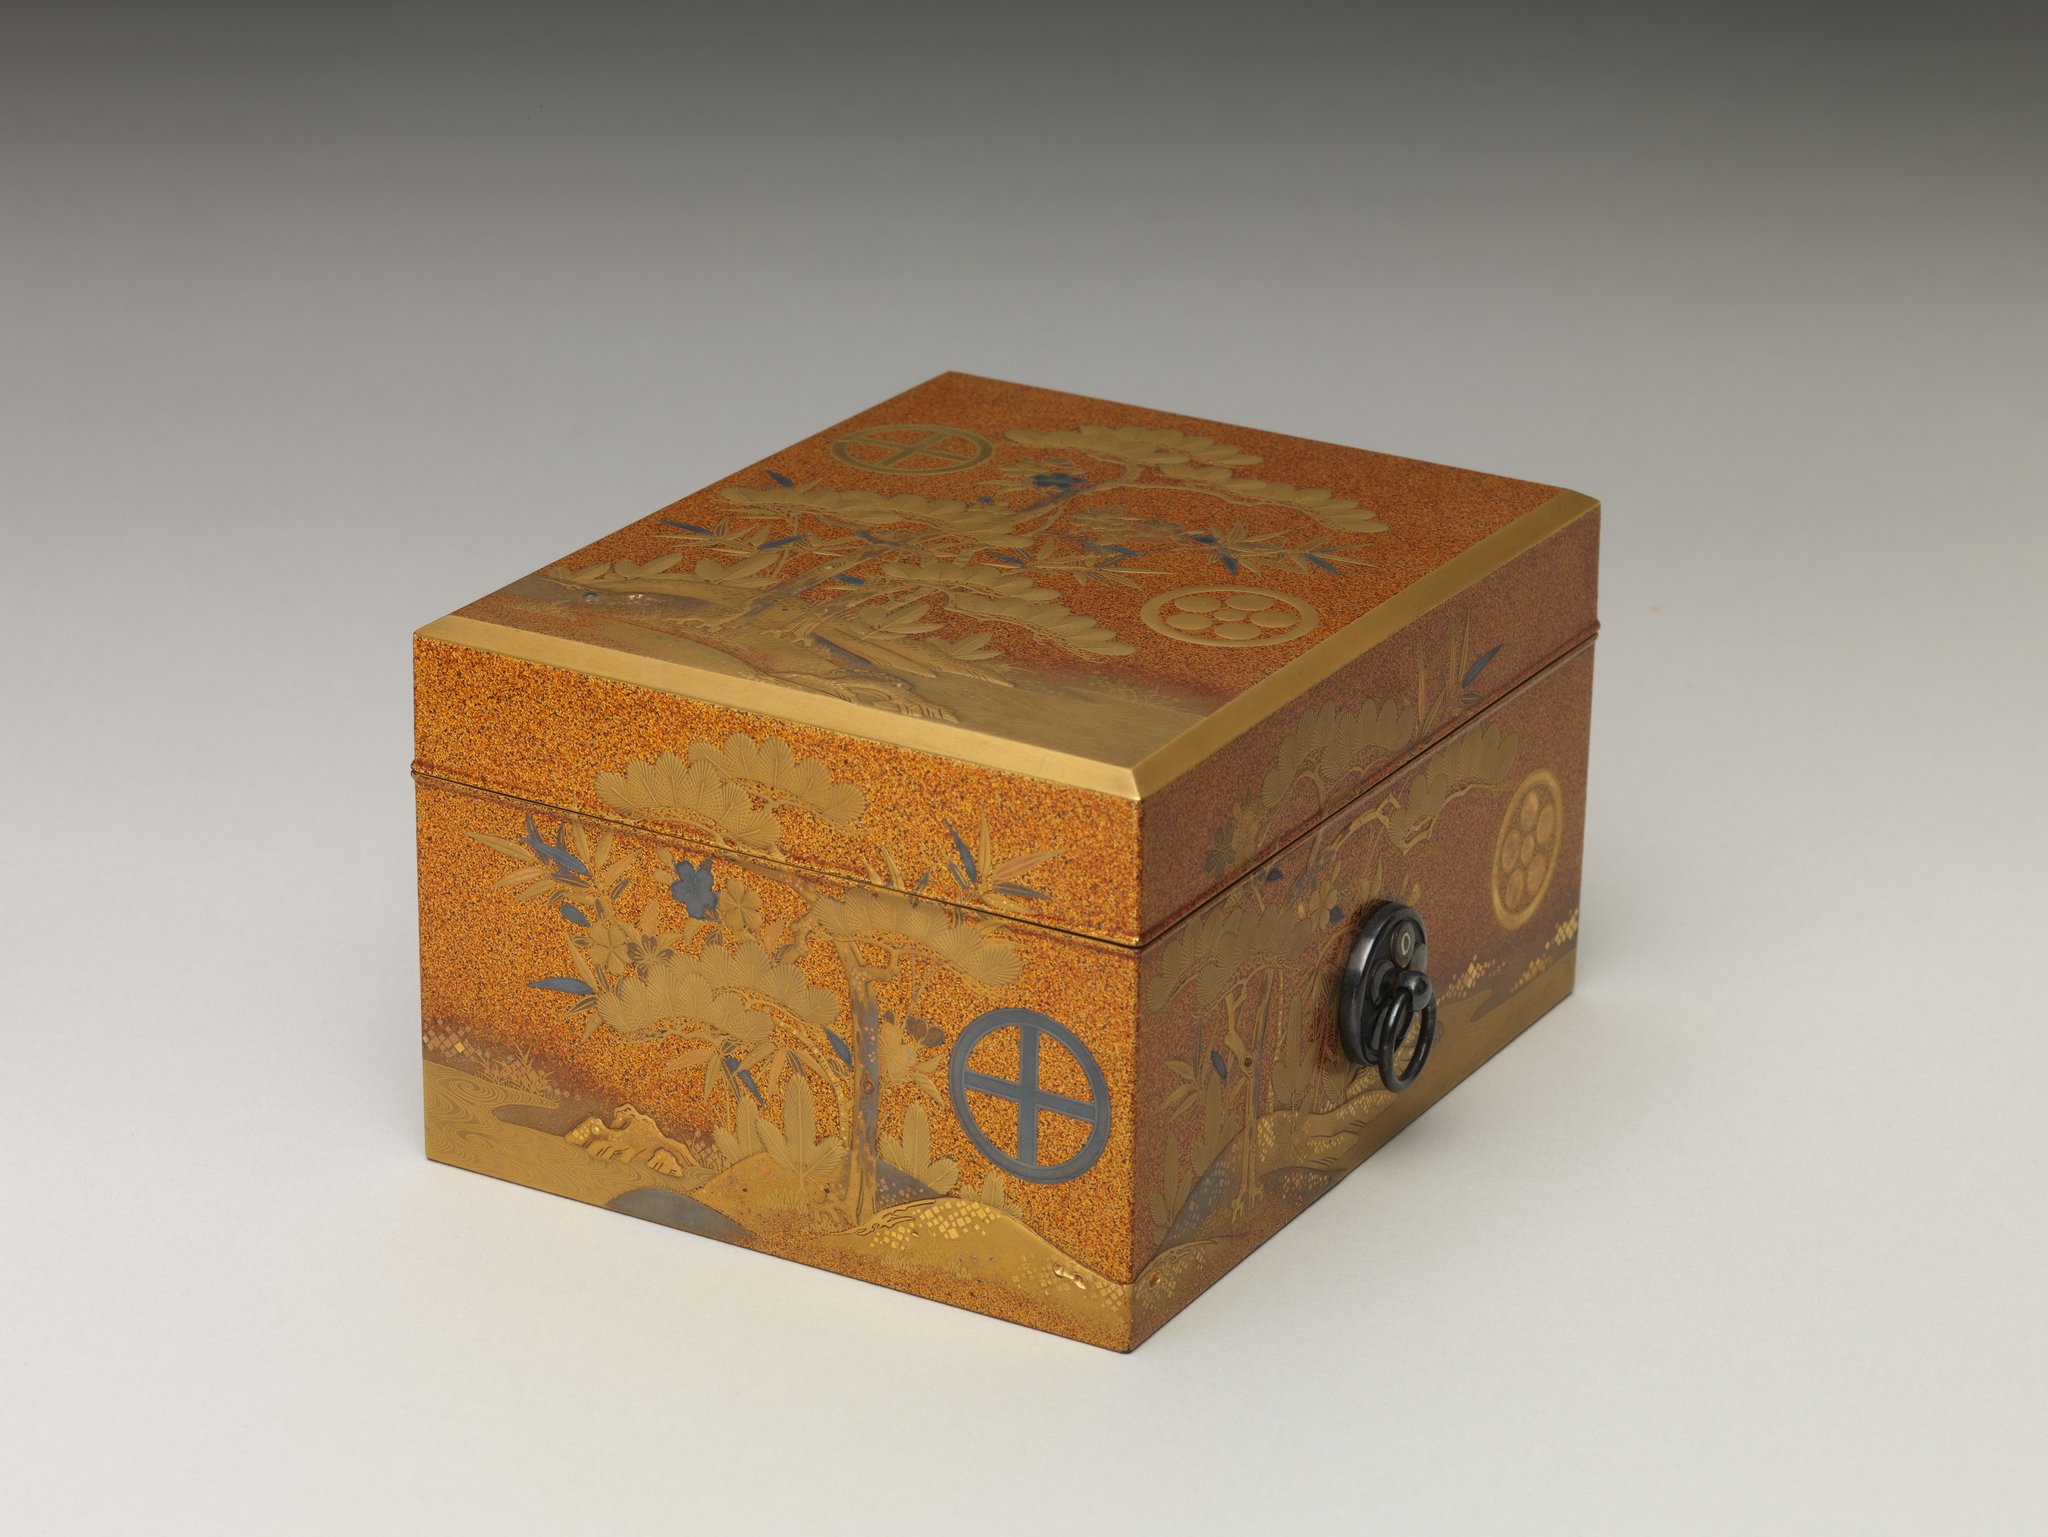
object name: box with lid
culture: japanese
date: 1801-1900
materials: gold, lacquer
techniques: maki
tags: trees